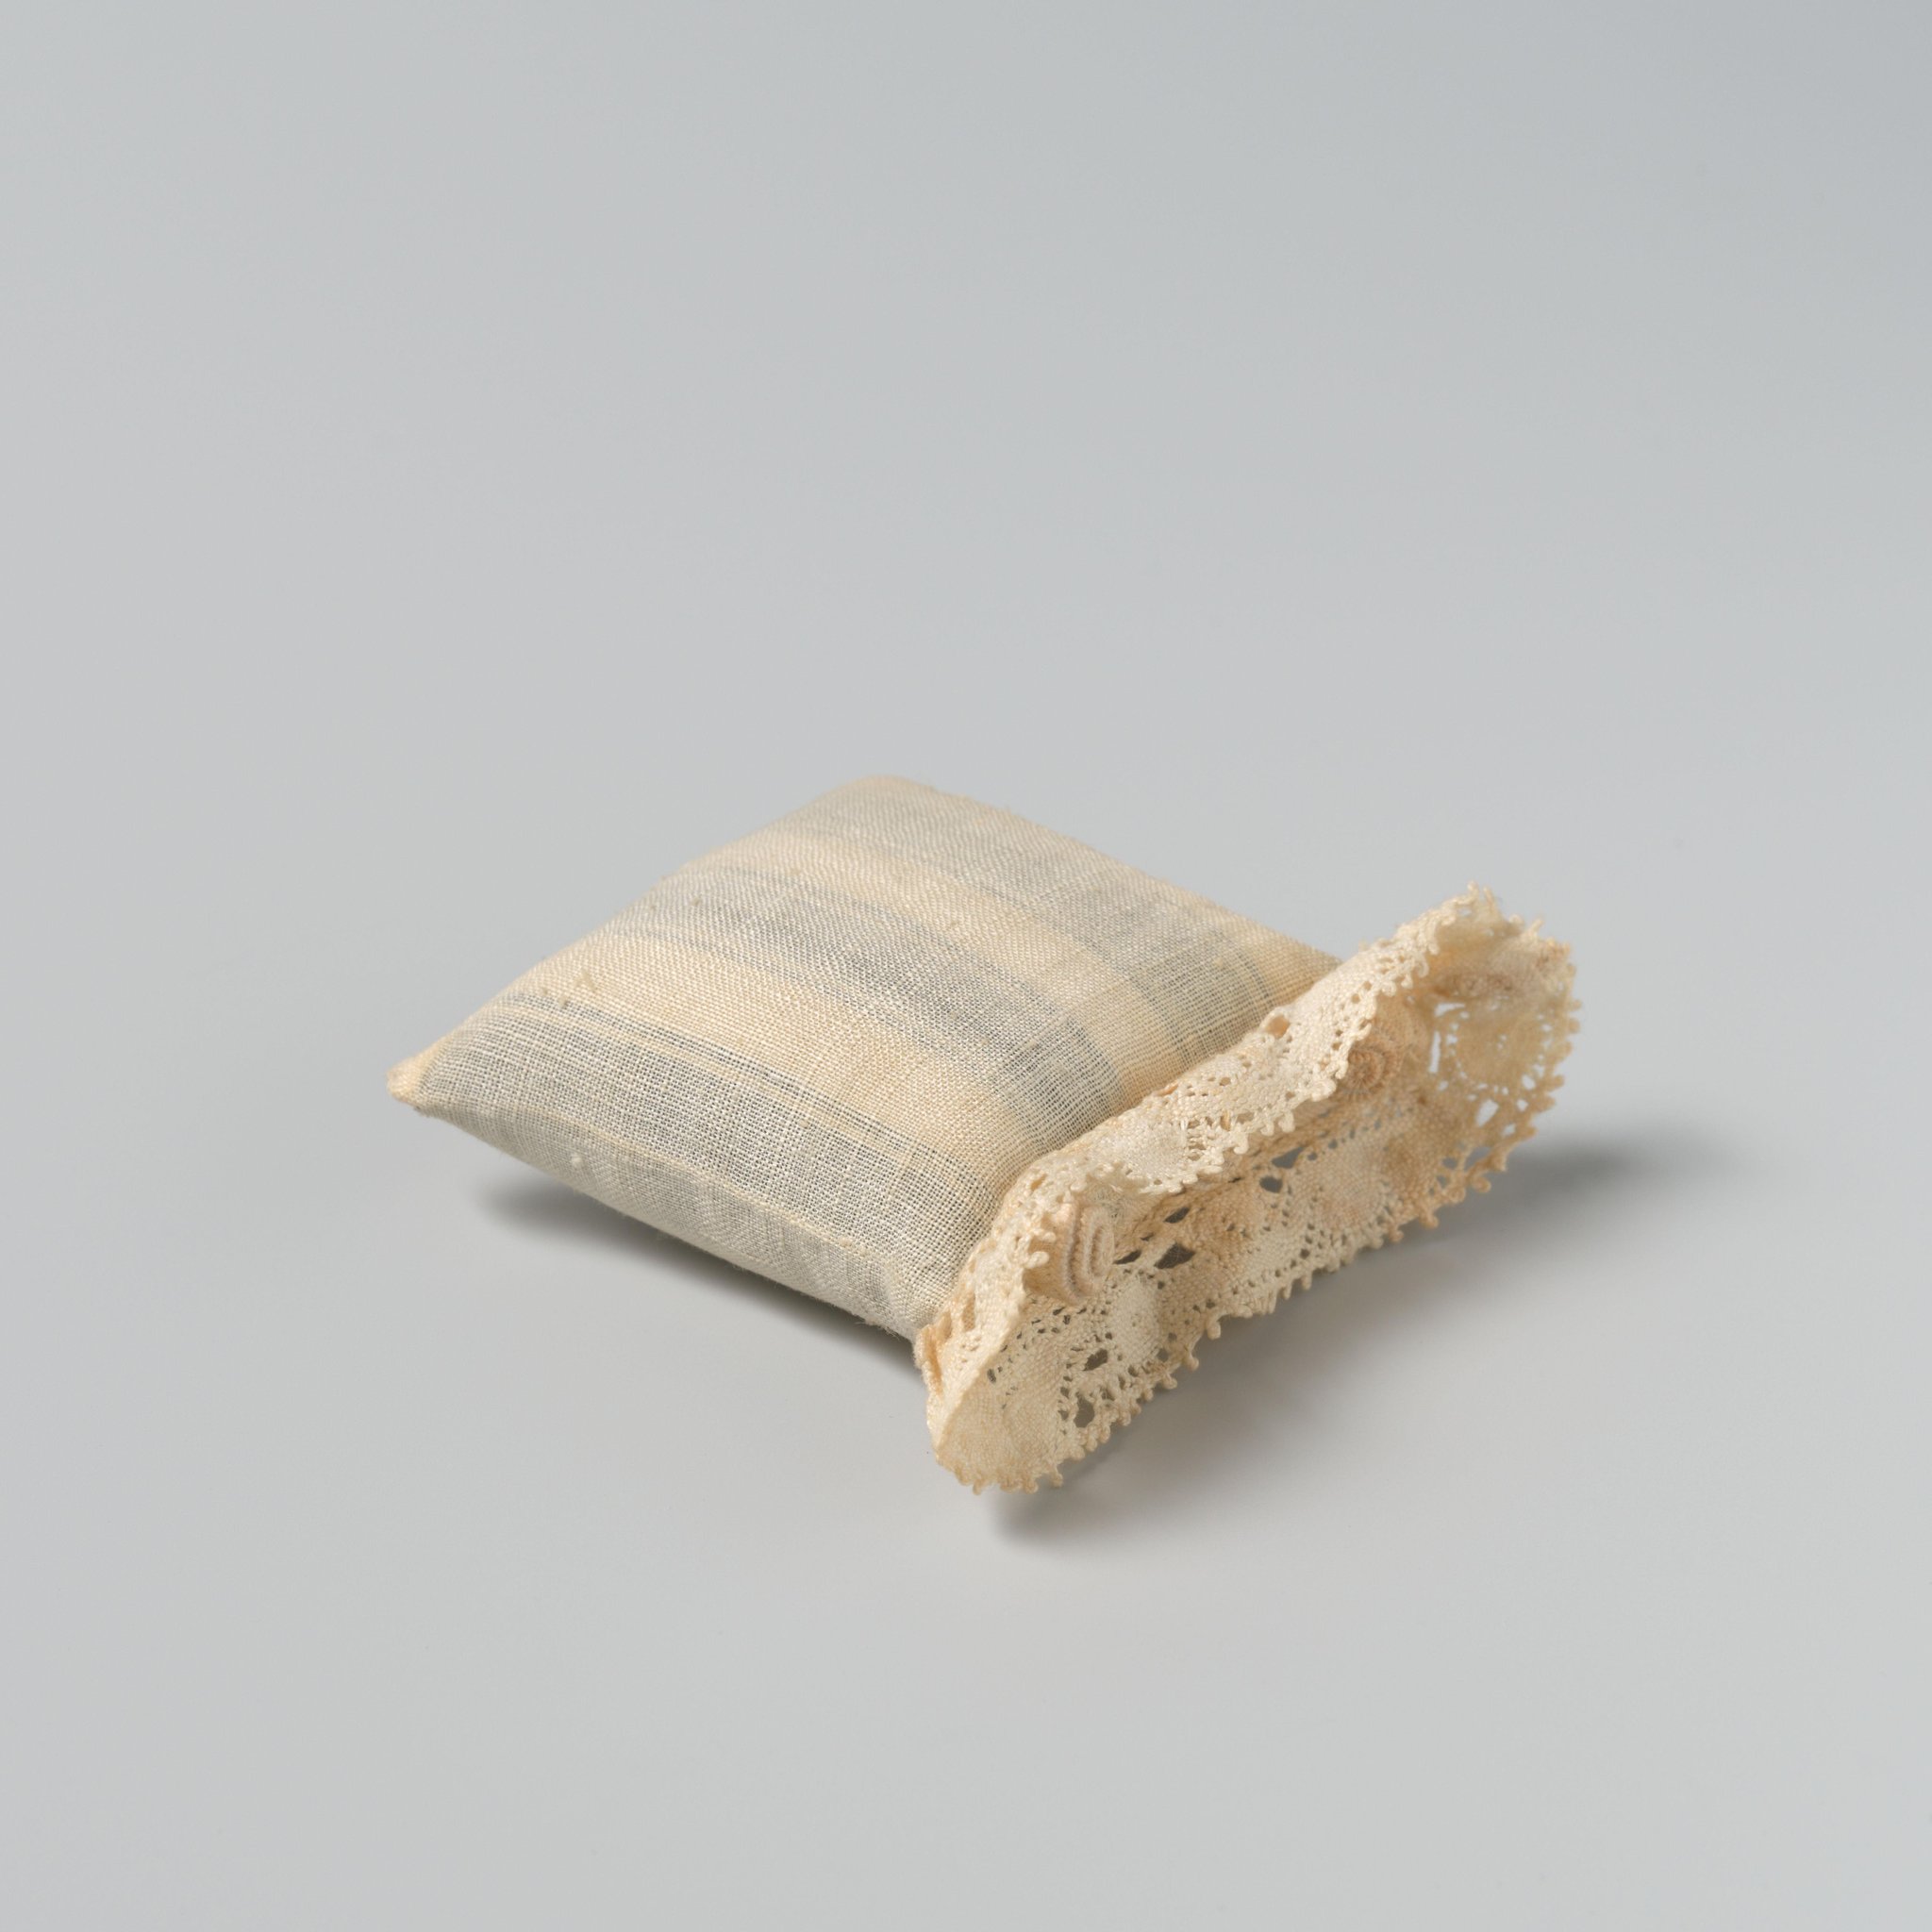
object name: miniature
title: Kussen van blauw linnen en witte katoen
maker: Anonymous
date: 1676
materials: cotton, linen, mineral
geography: amsterdam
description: Kussen van gestreept weefsel van blauw linnen en witte katoen, gevuld met een harde, zware substantie.